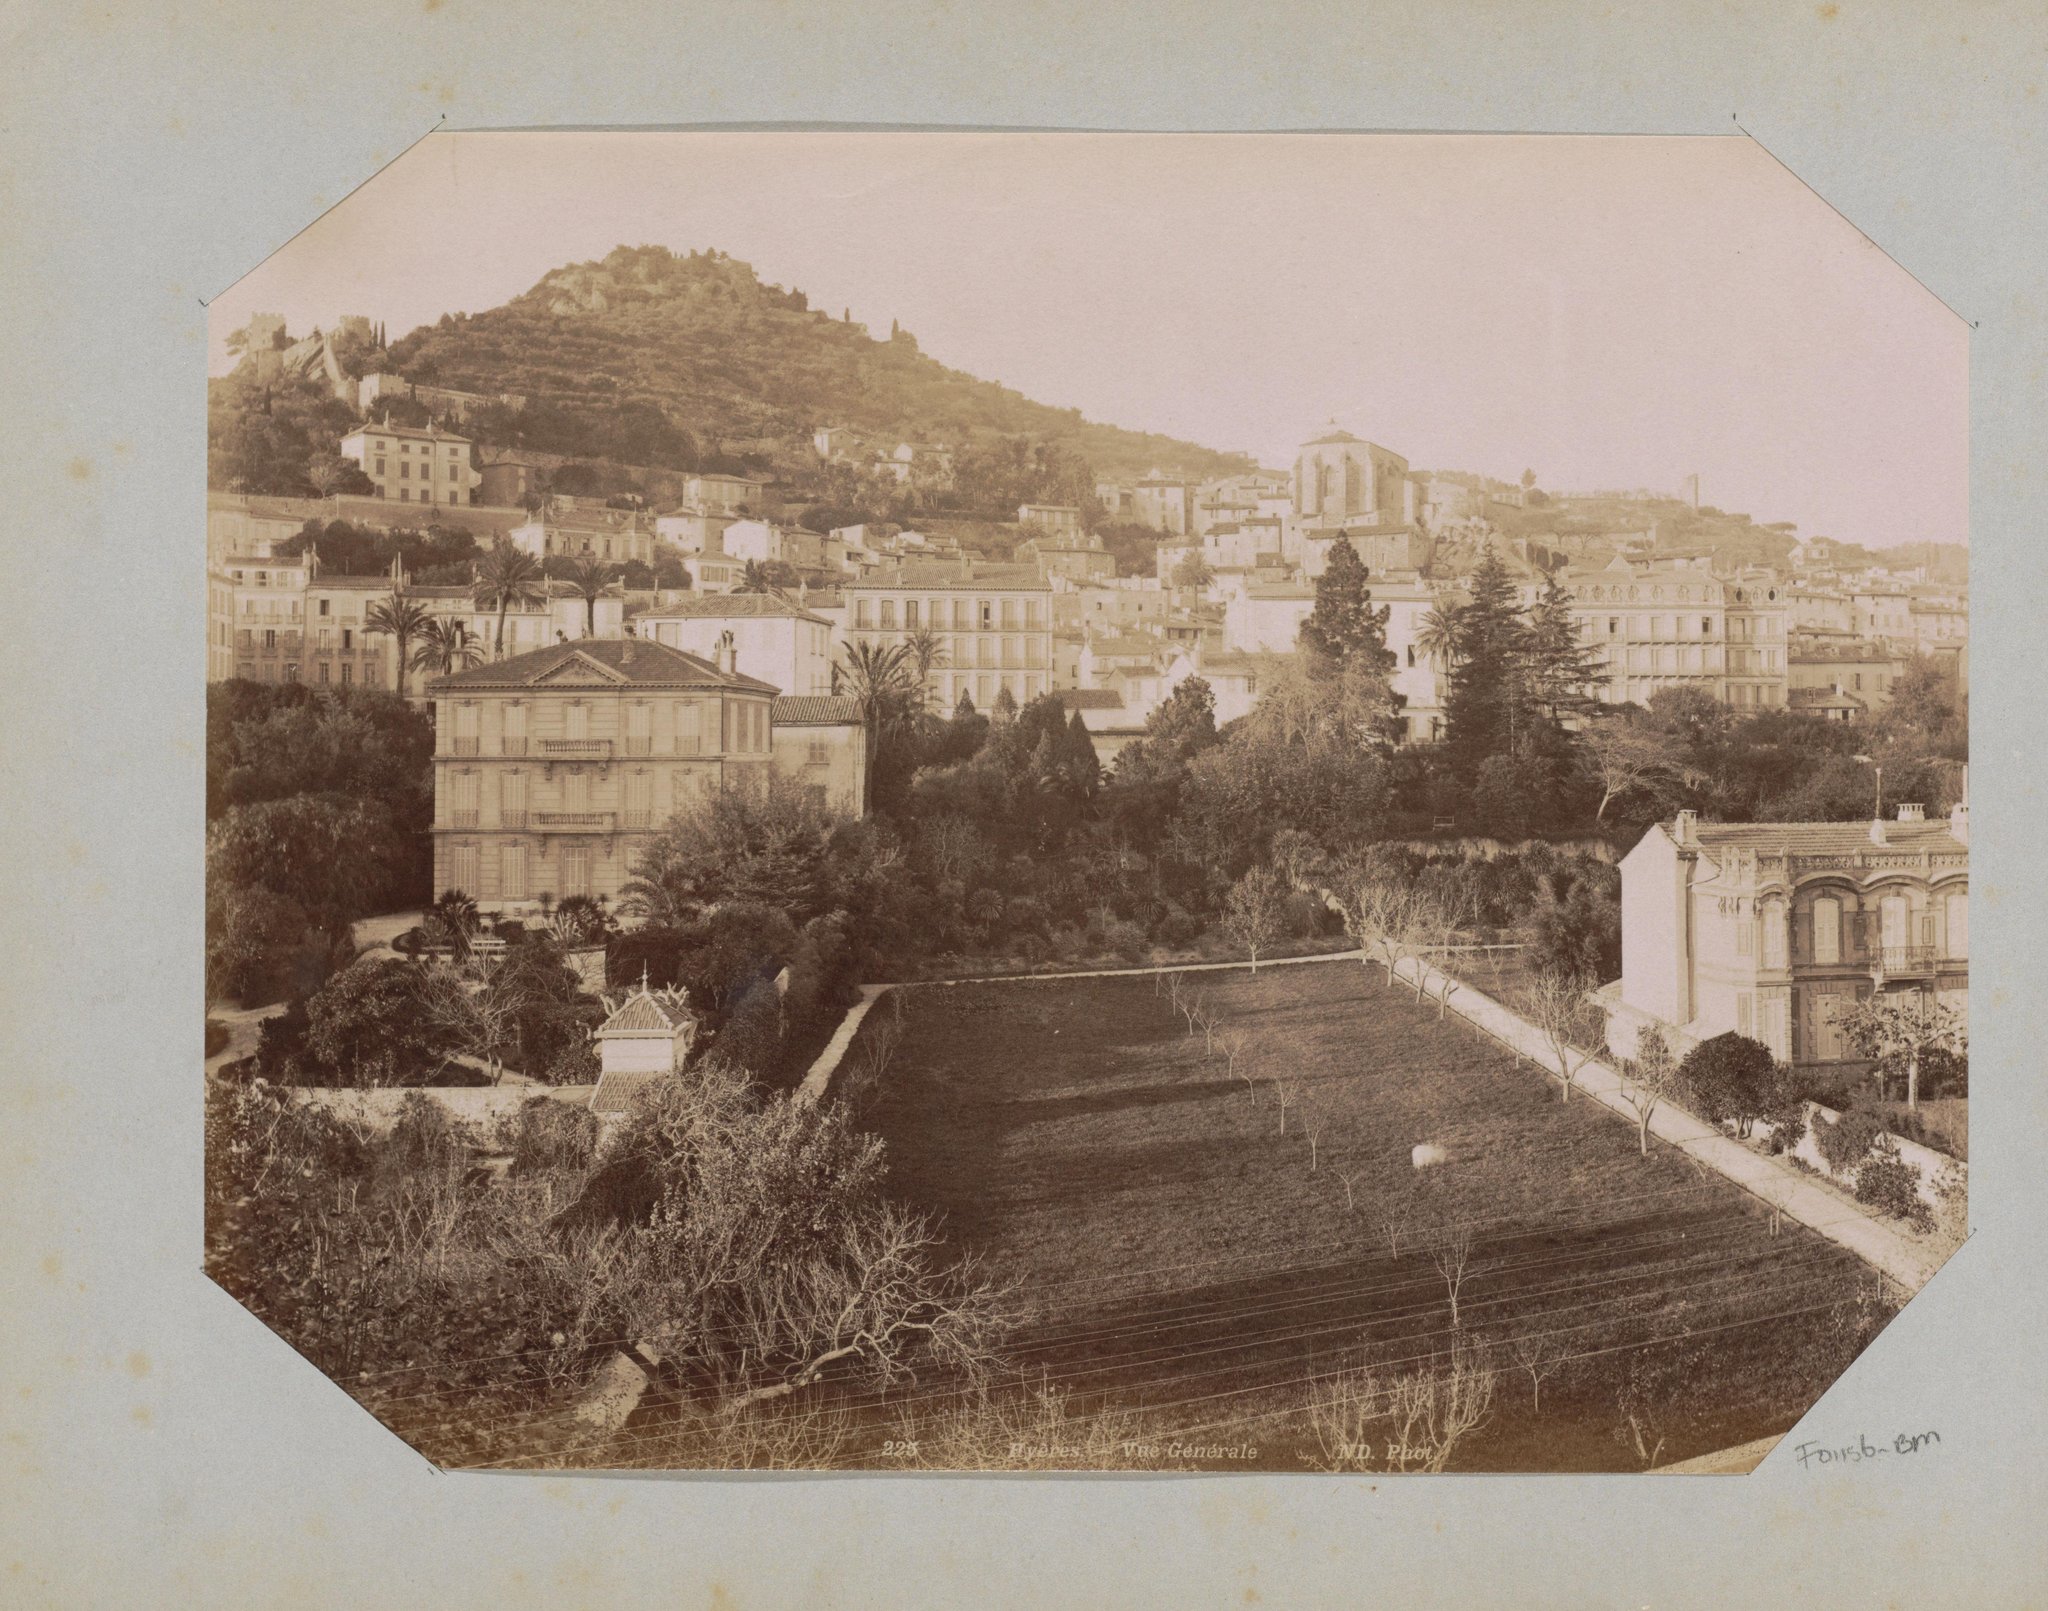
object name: photograph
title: Gezicht op Hyères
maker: étienne neurdein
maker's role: publisher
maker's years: 1832-1918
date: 1896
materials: photographic support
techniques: albumen print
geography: hyères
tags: city-view in general; 'veduta'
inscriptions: inscription: ‘225 Hyères - Vue Générale N.D. Phot.’